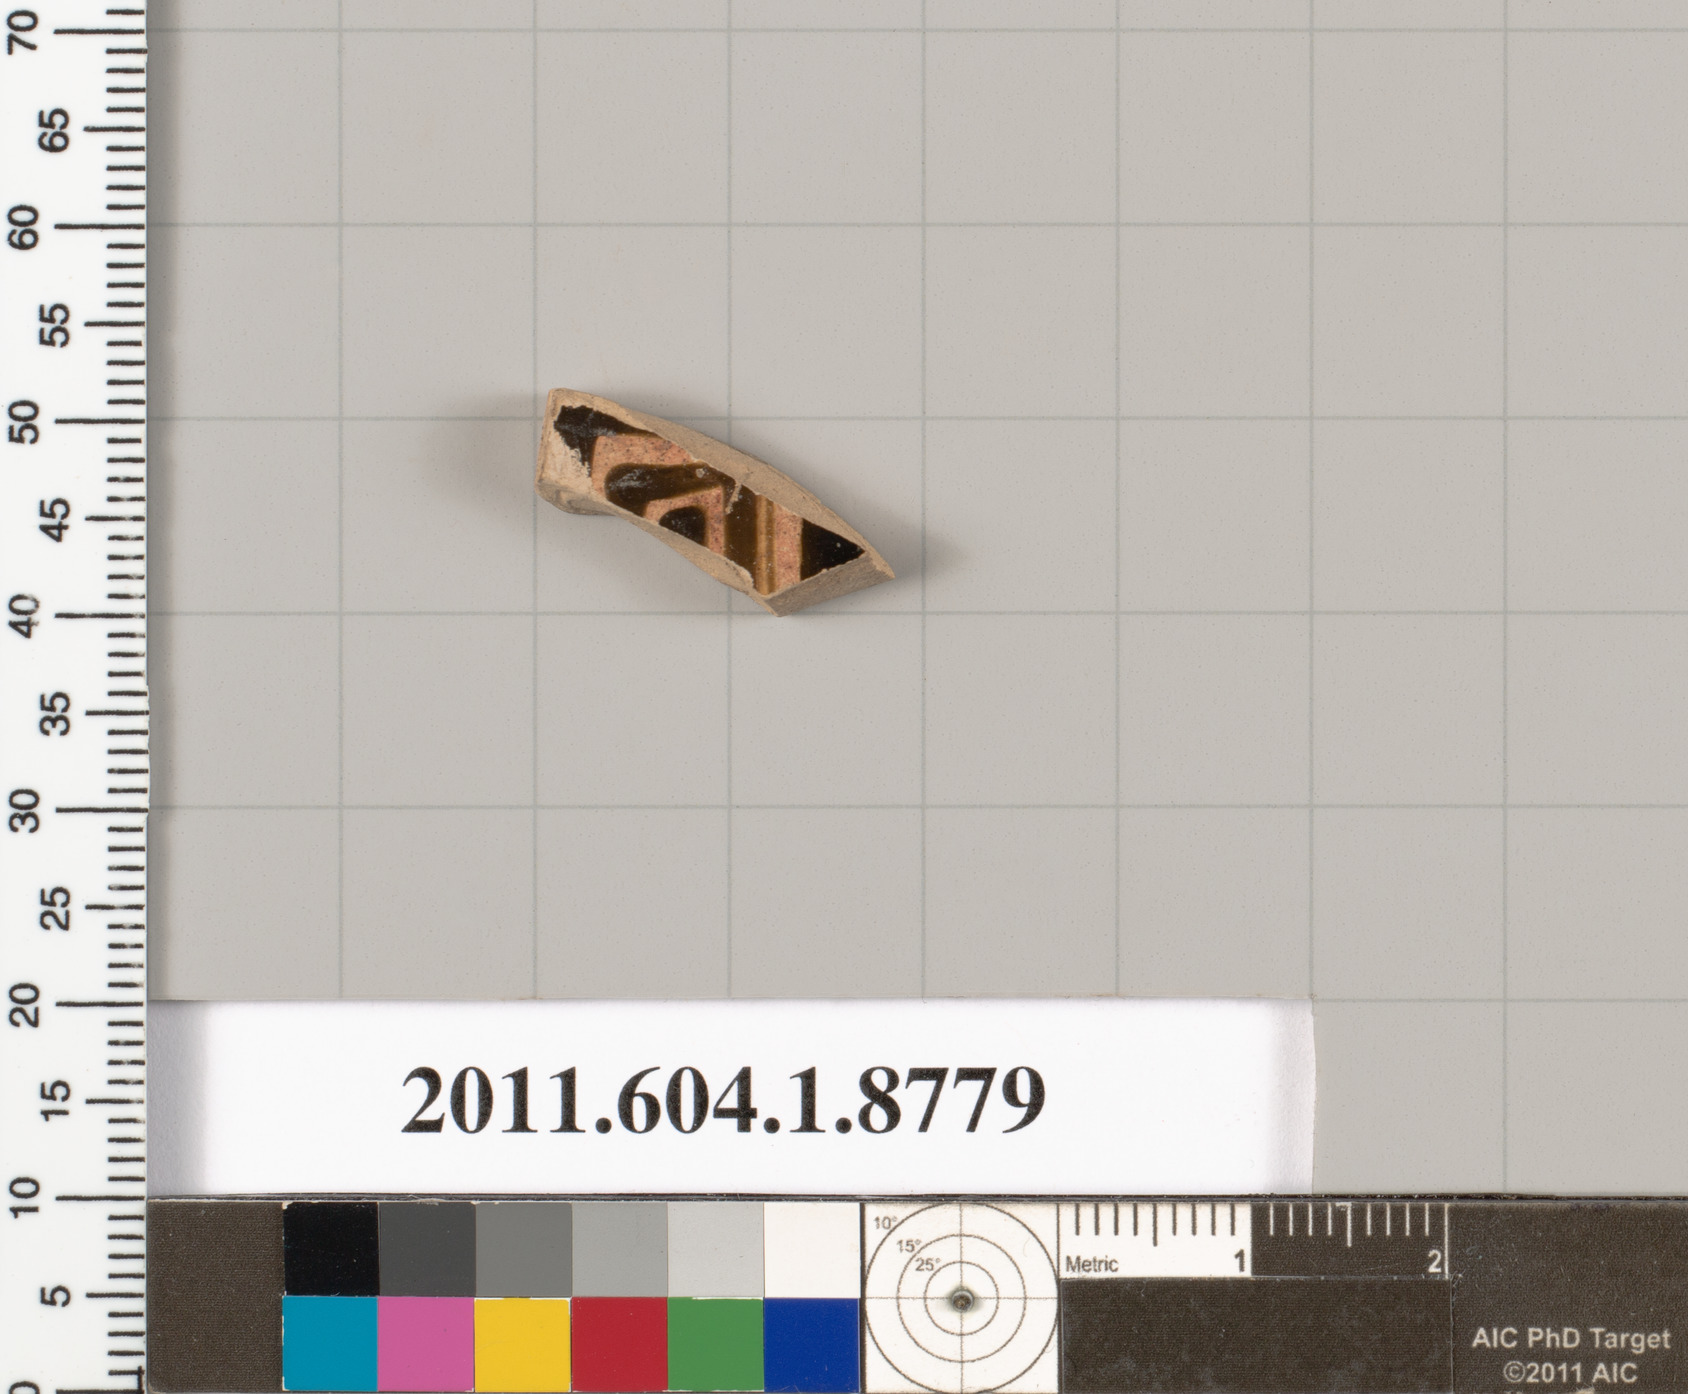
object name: kylix fragment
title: Terracotta fragment of a kylix (drinking cup)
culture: greek, attic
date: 460-440 BCE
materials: terracotta